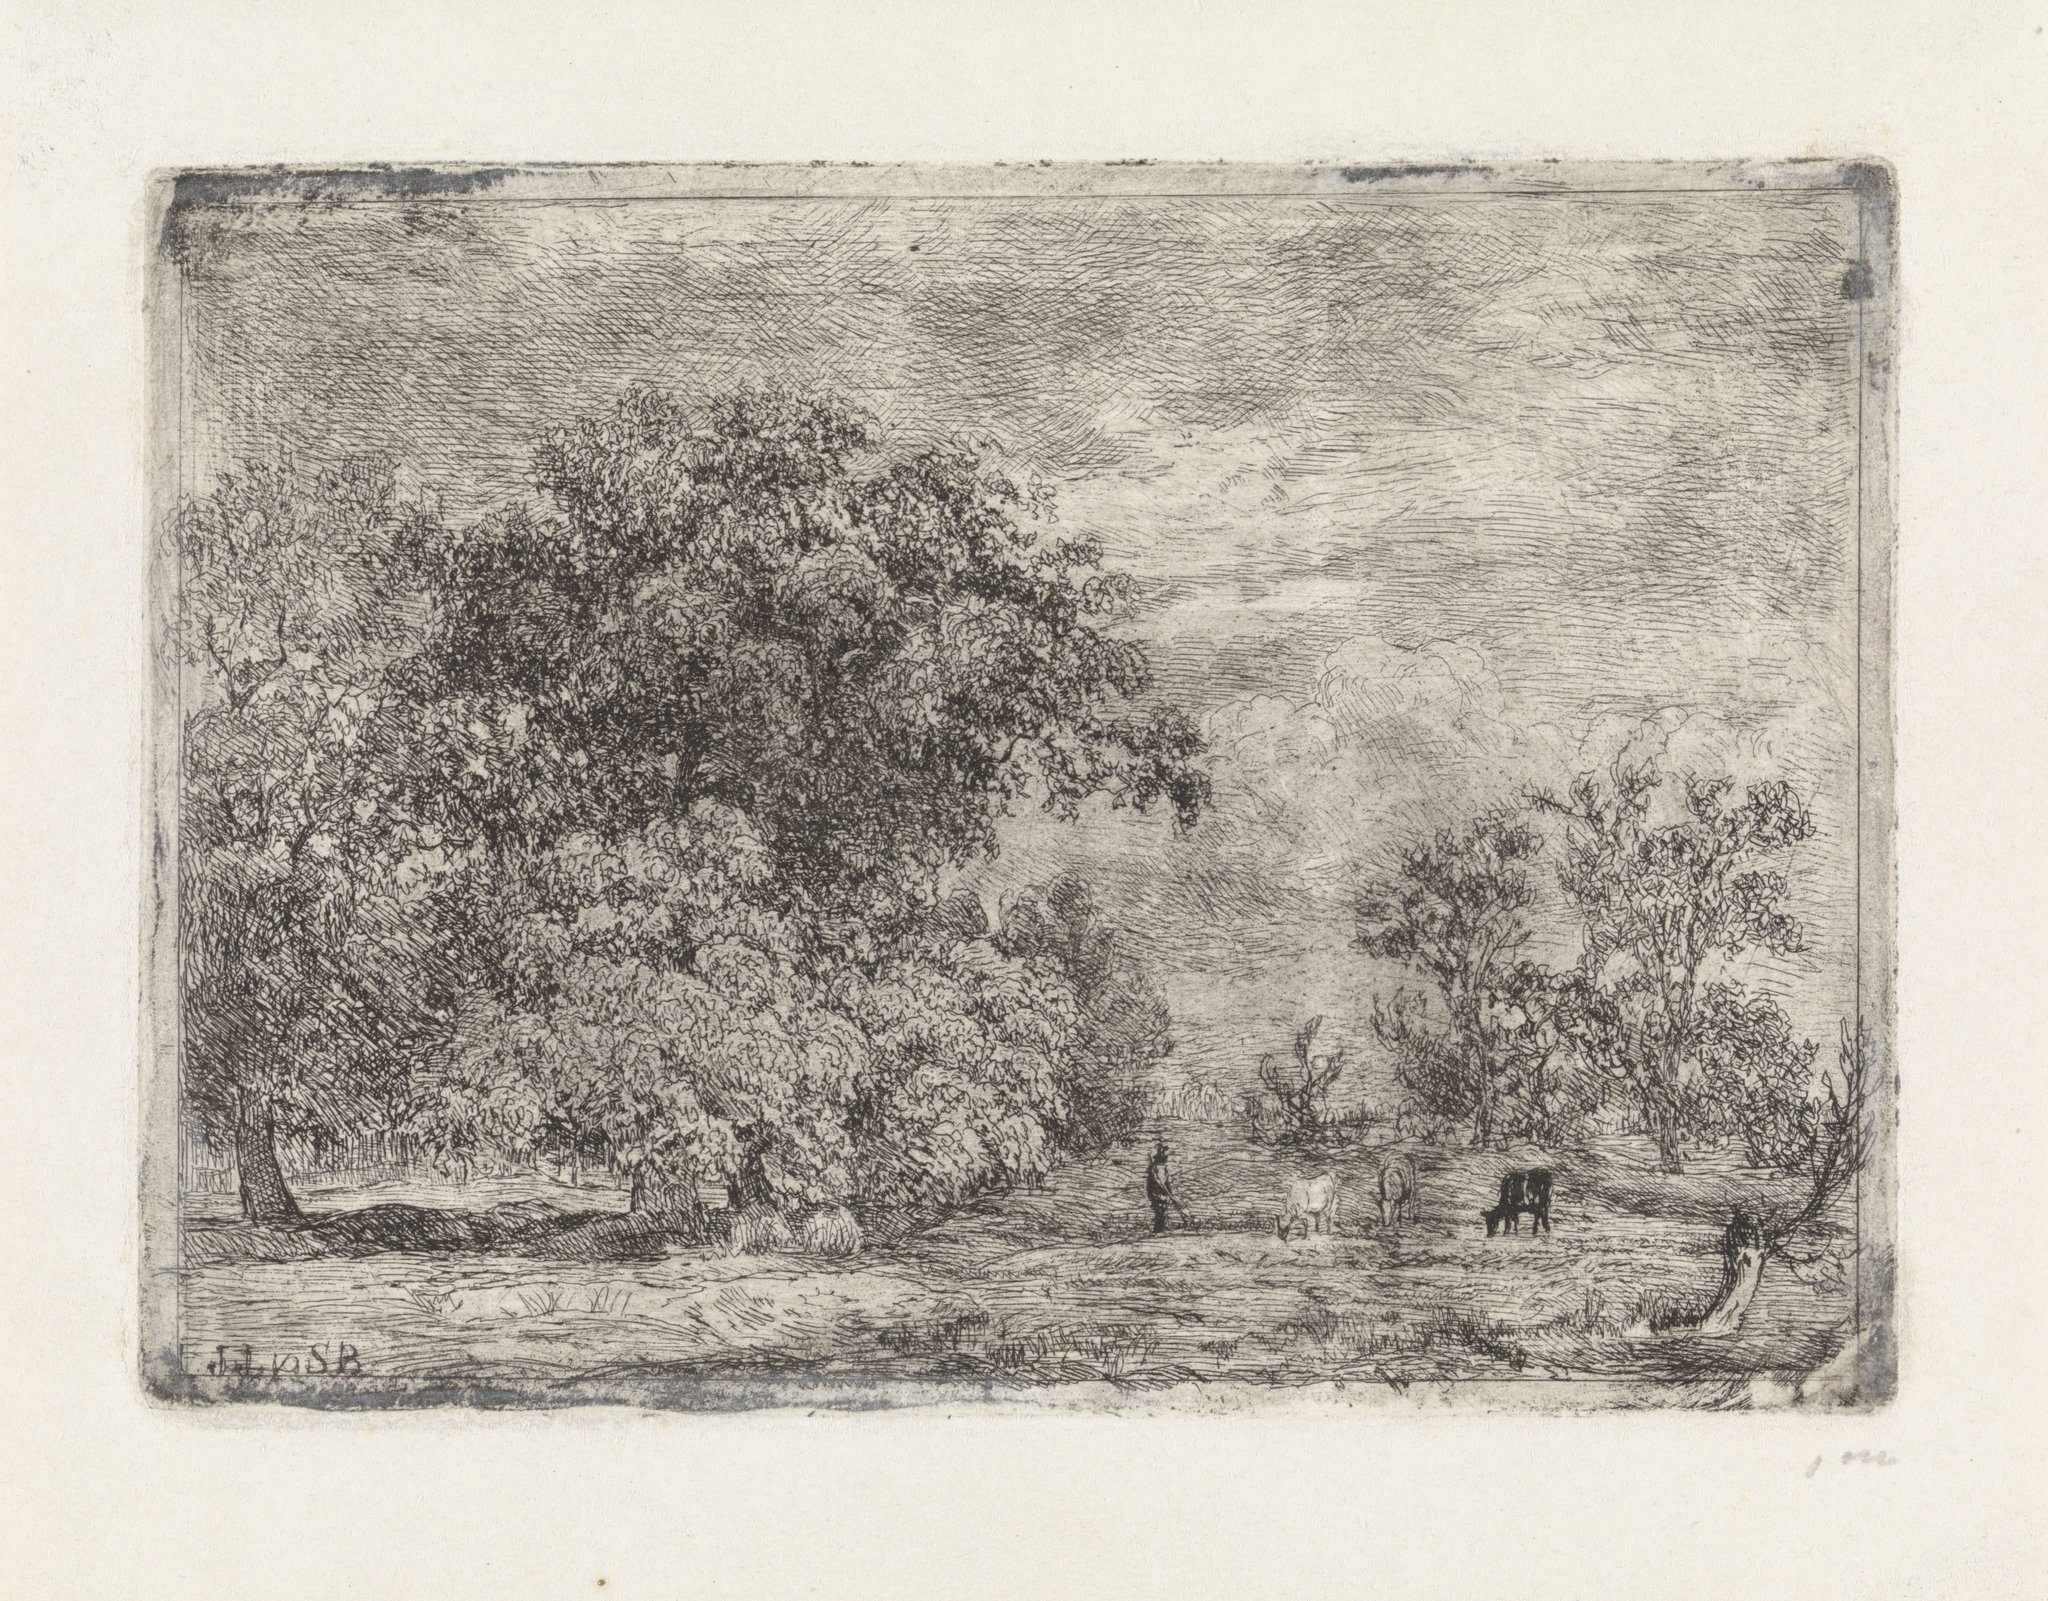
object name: print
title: Landschap met bomen en drie grazende koeien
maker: julius jacobus van de sande bakhuyzen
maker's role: draughtsman, painter, print maker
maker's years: 1835-1925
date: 1845-1892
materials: paper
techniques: drypoint, etching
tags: angels fighting, landscapes in the temperate zone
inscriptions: collector's mark: Lugt 2228